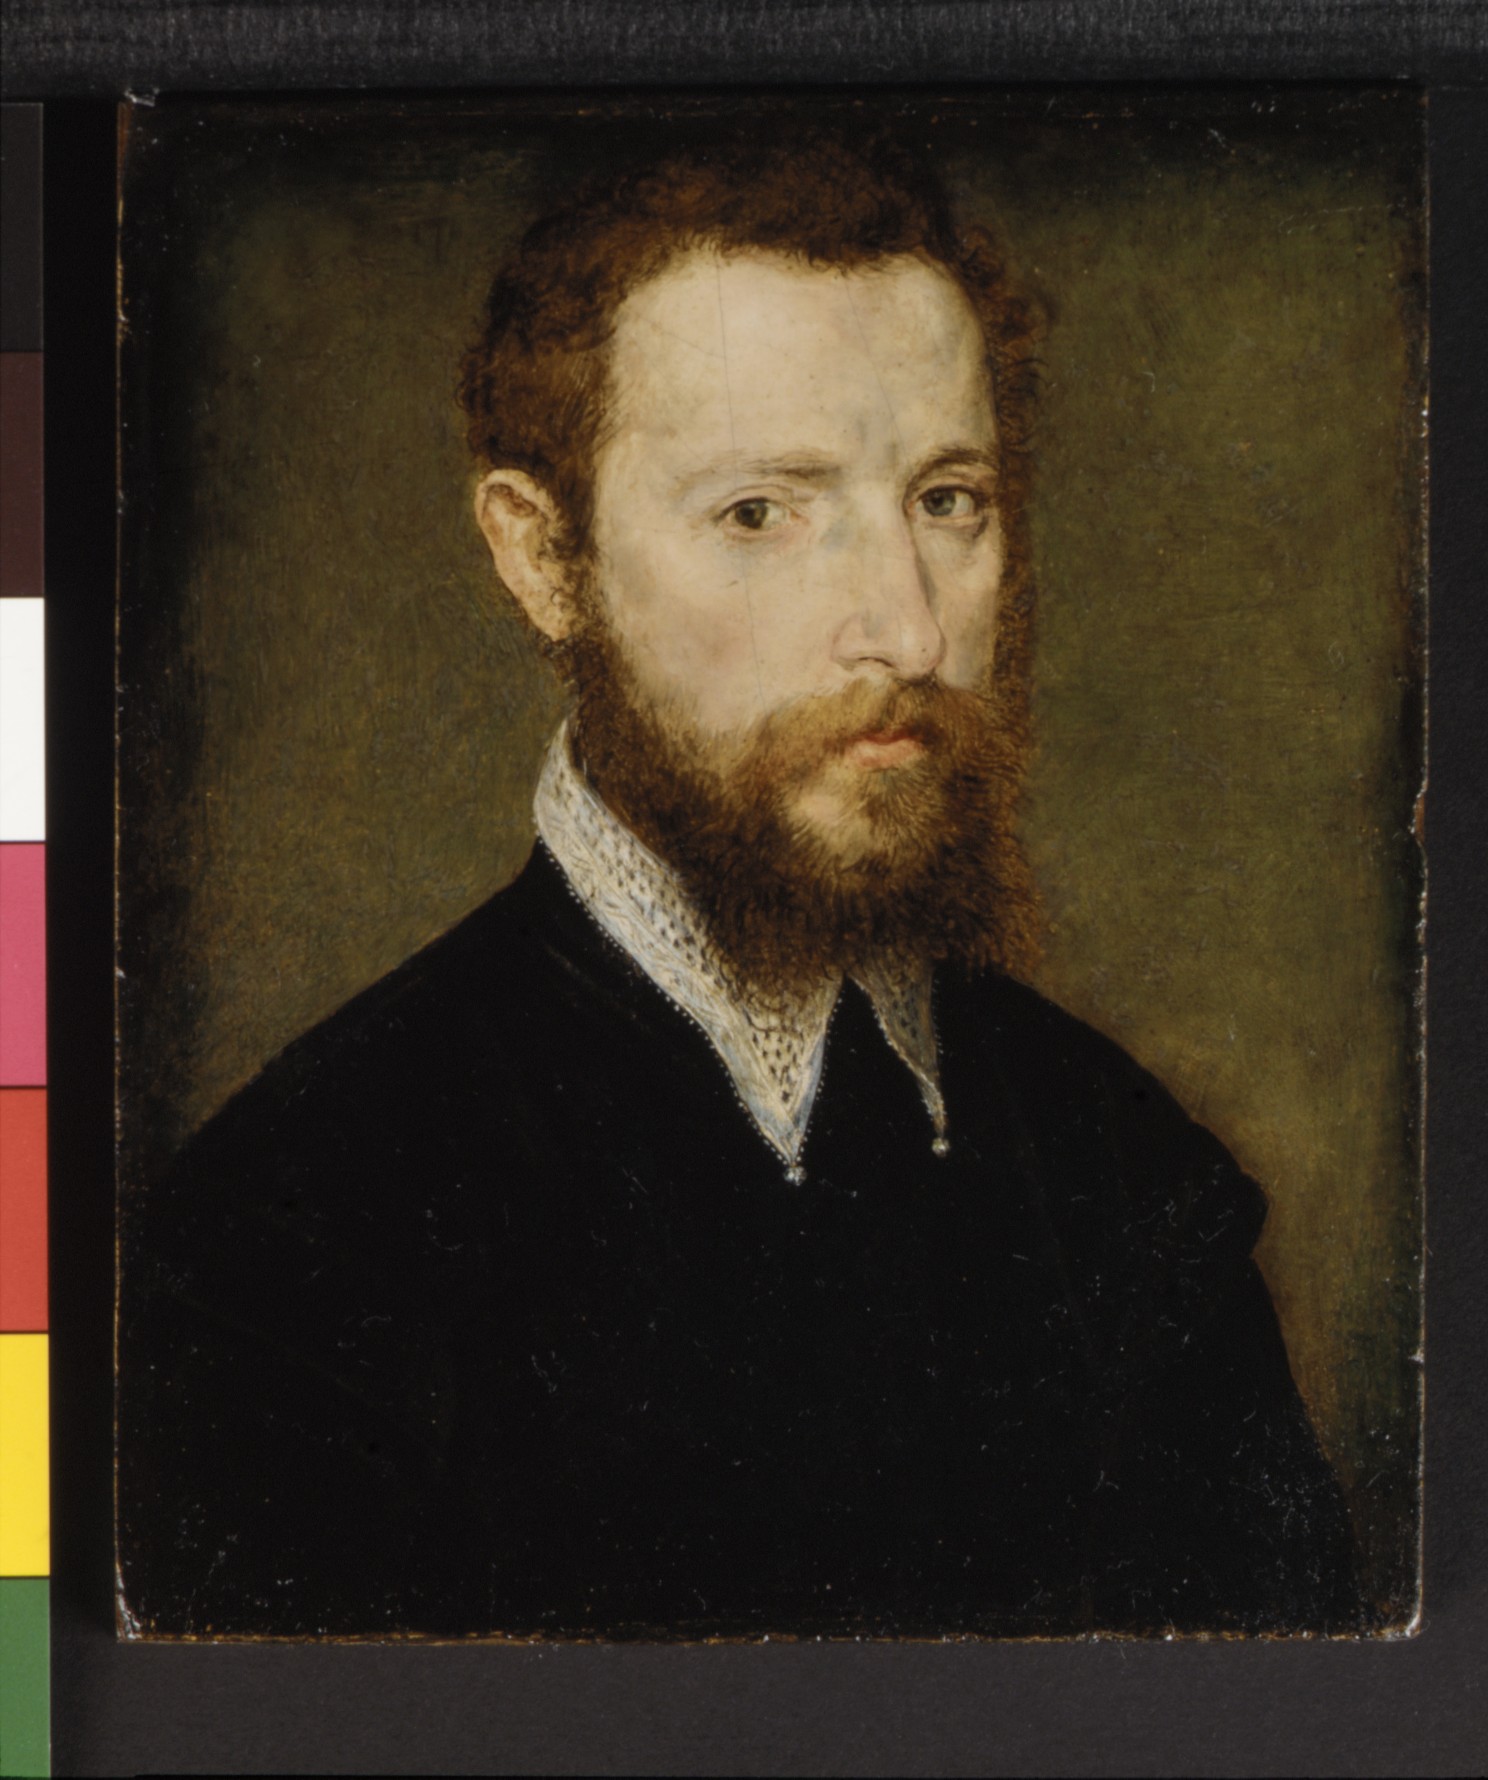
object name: painting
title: Portrait of a Man with a Pointed Collar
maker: corneille de lyon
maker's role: artist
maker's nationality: netherlandish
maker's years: 1533-1575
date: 1533-1575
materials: oil, wood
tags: men,portraits